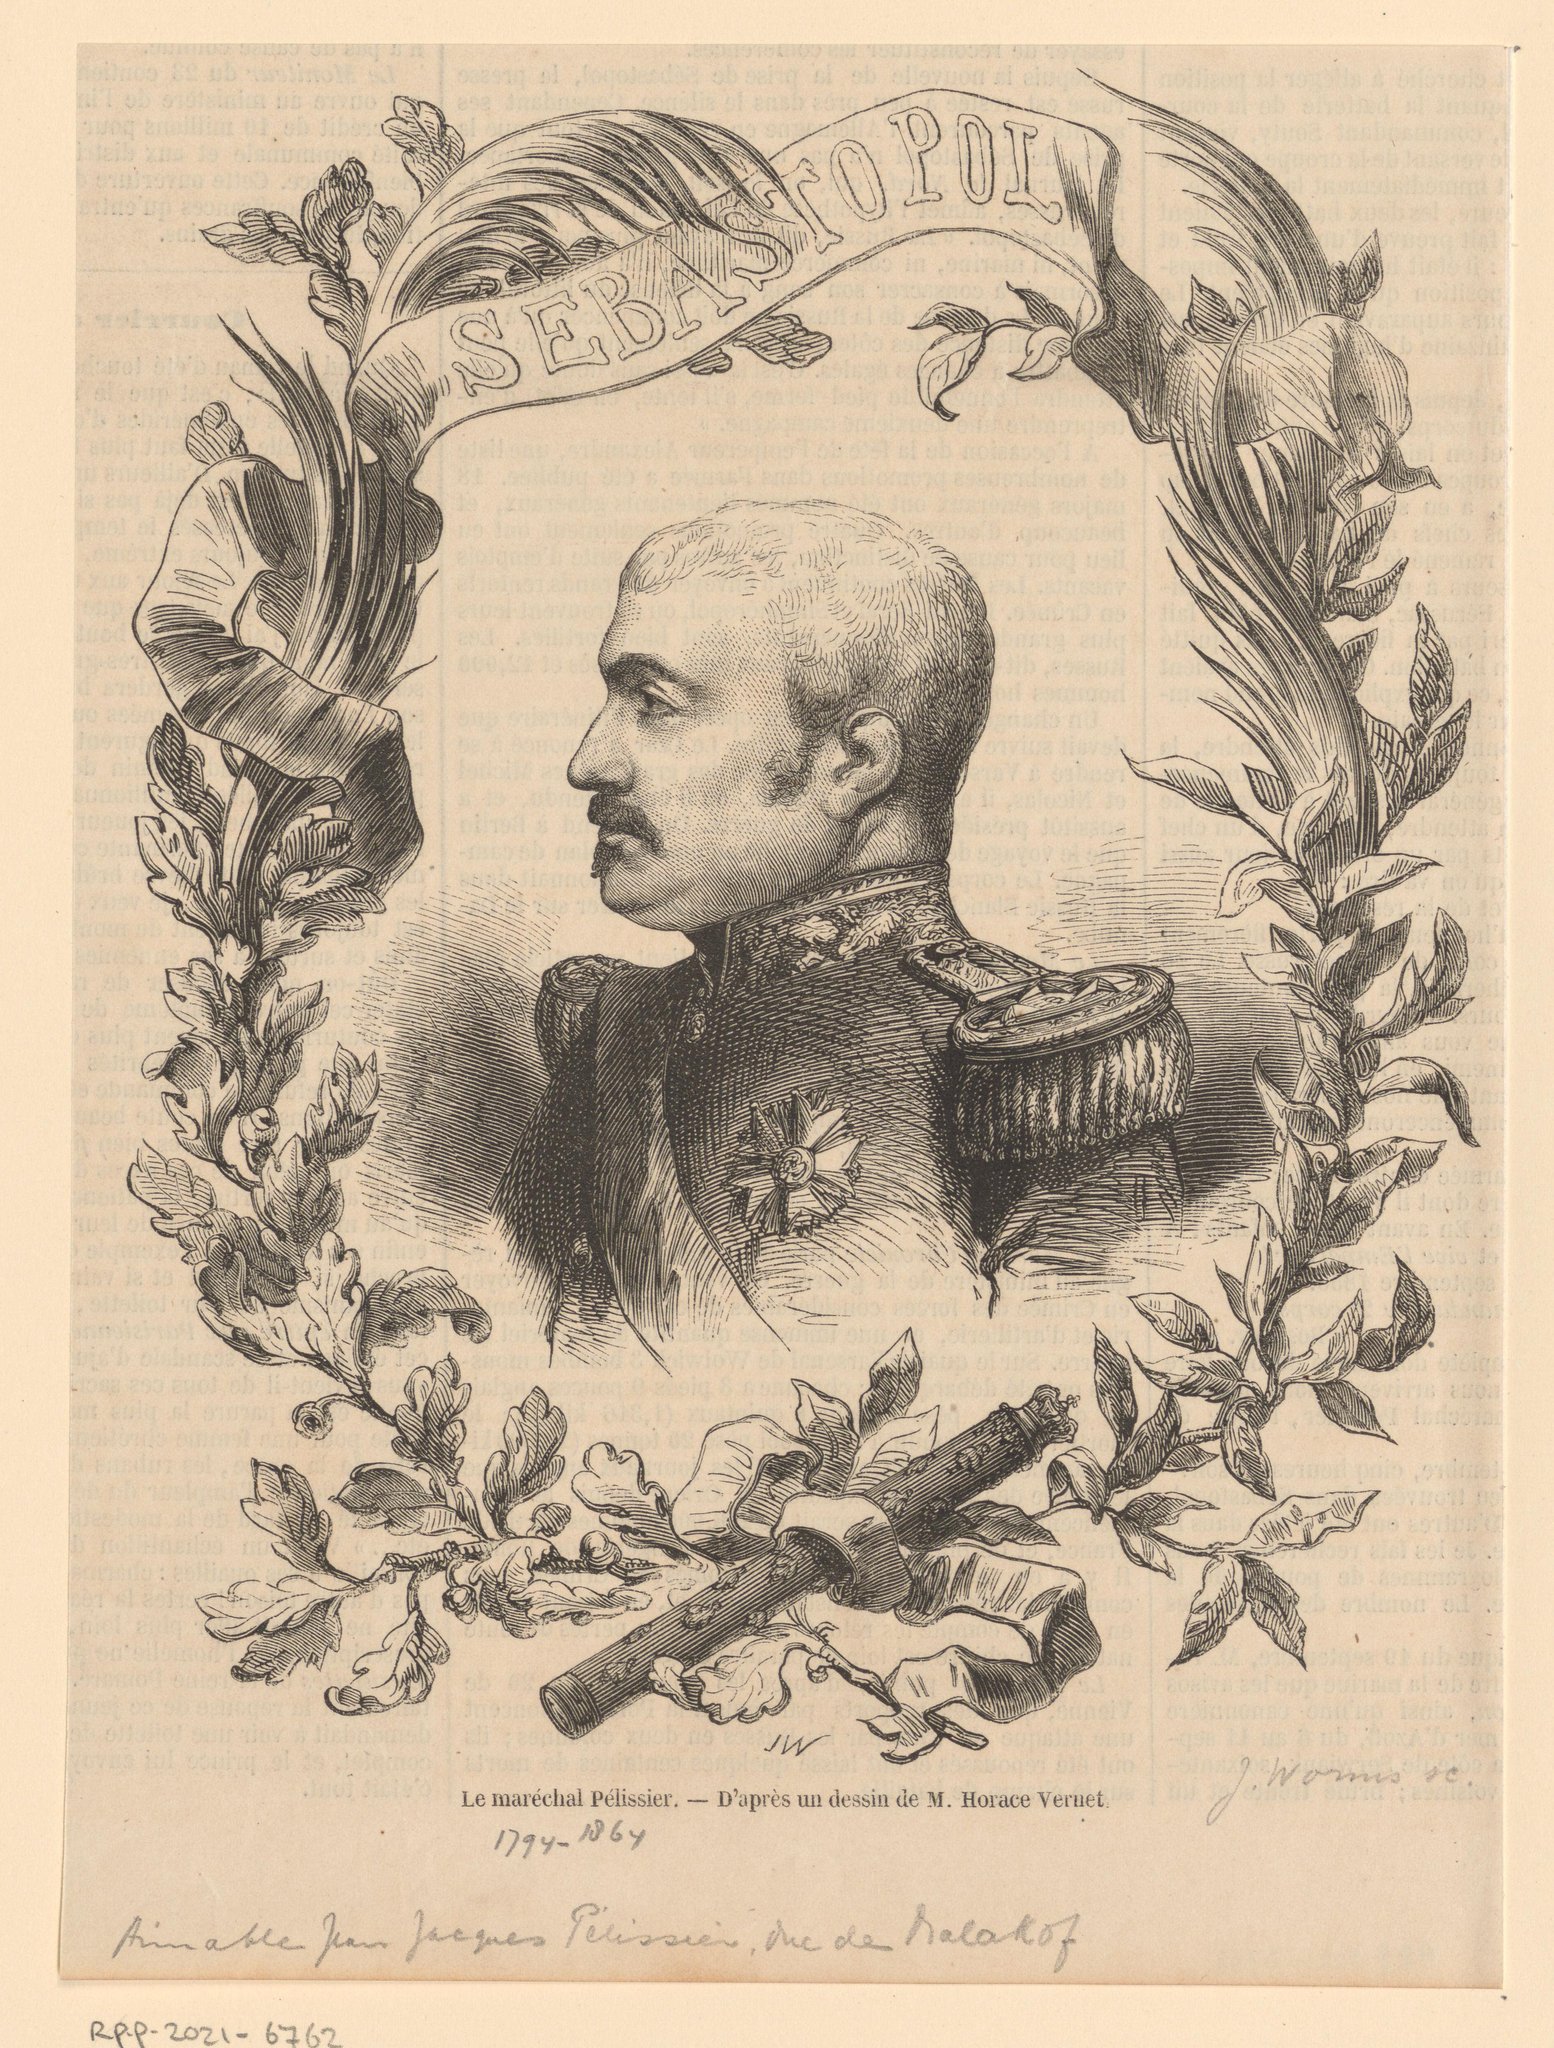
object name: print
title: Portret van Aimable Jean Jacques Pélissier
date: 1855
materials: paper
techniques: letterpress printing, engraving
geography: paris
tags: adult man, historical persons, (military) uniforms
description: Prent uit: L'illustration, journal universel 26 (1855), nr. 657, 29 september 1855.